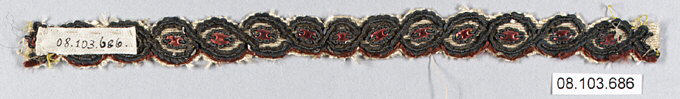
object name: passementerie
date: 1701-1800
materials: metal thread